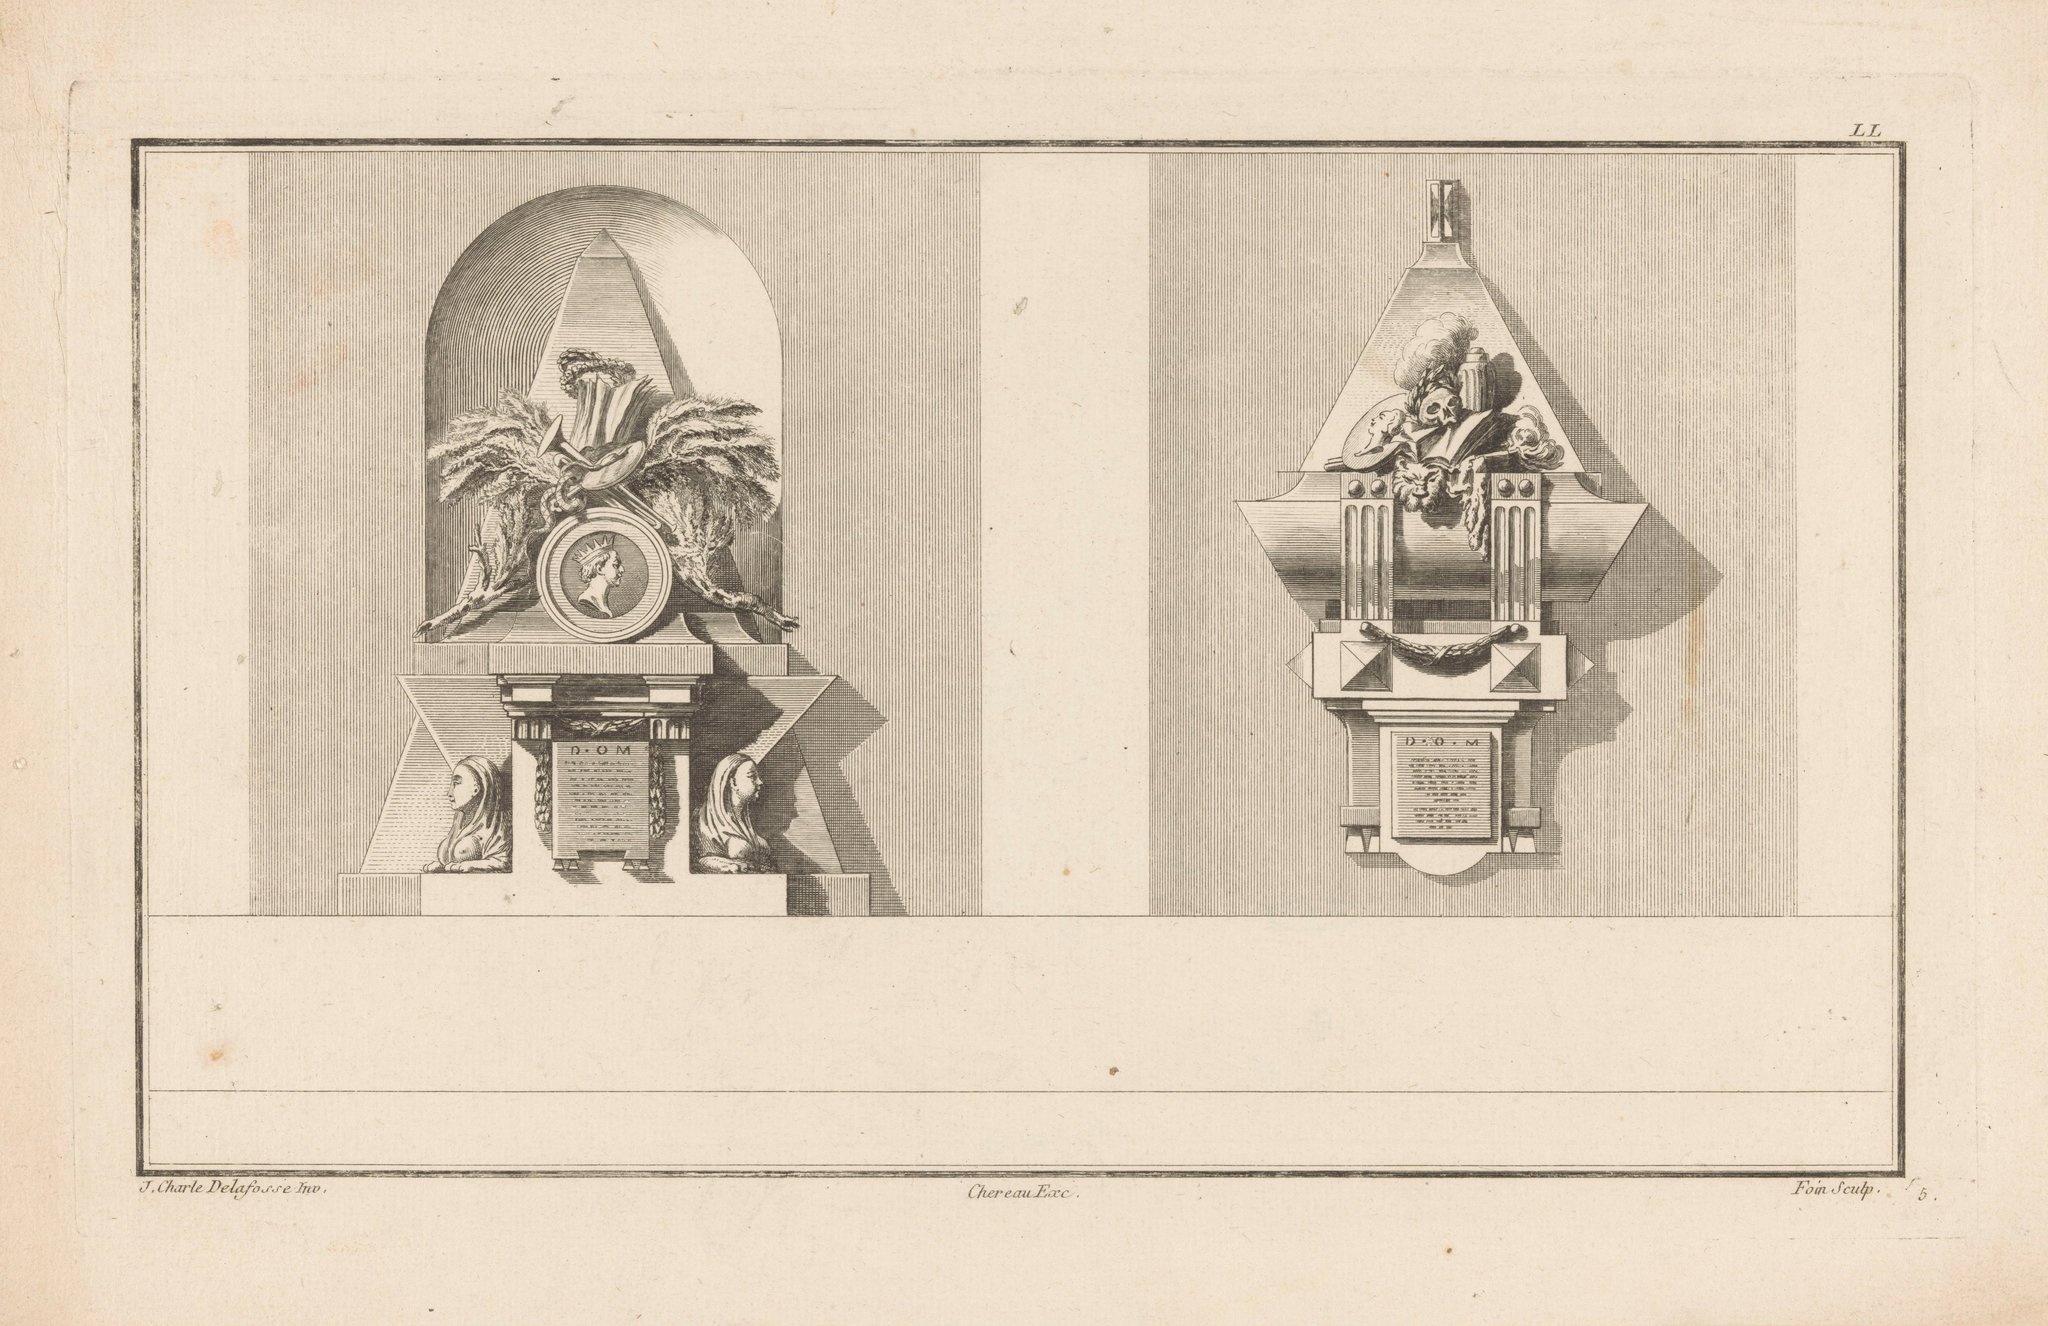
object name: ornament print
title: 35e Cahier LL Cahier de Vases, Fontaines et Tombeaux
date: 1771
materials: paper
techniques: engraving, etching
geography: paris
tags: niche-tomb, wall-tomb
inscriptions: collector's mark: Lugt 2760, collector's mark: Lugt 2228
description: Links een tombe in een nis met sfinxen, een medaillon met gekroond portret en profil, takken, een trompet en kransen. Rechts een muurtombe met een dierenvel, een medaillon met portret, een gelauwerde schedel, een fakkel en een zandloper.